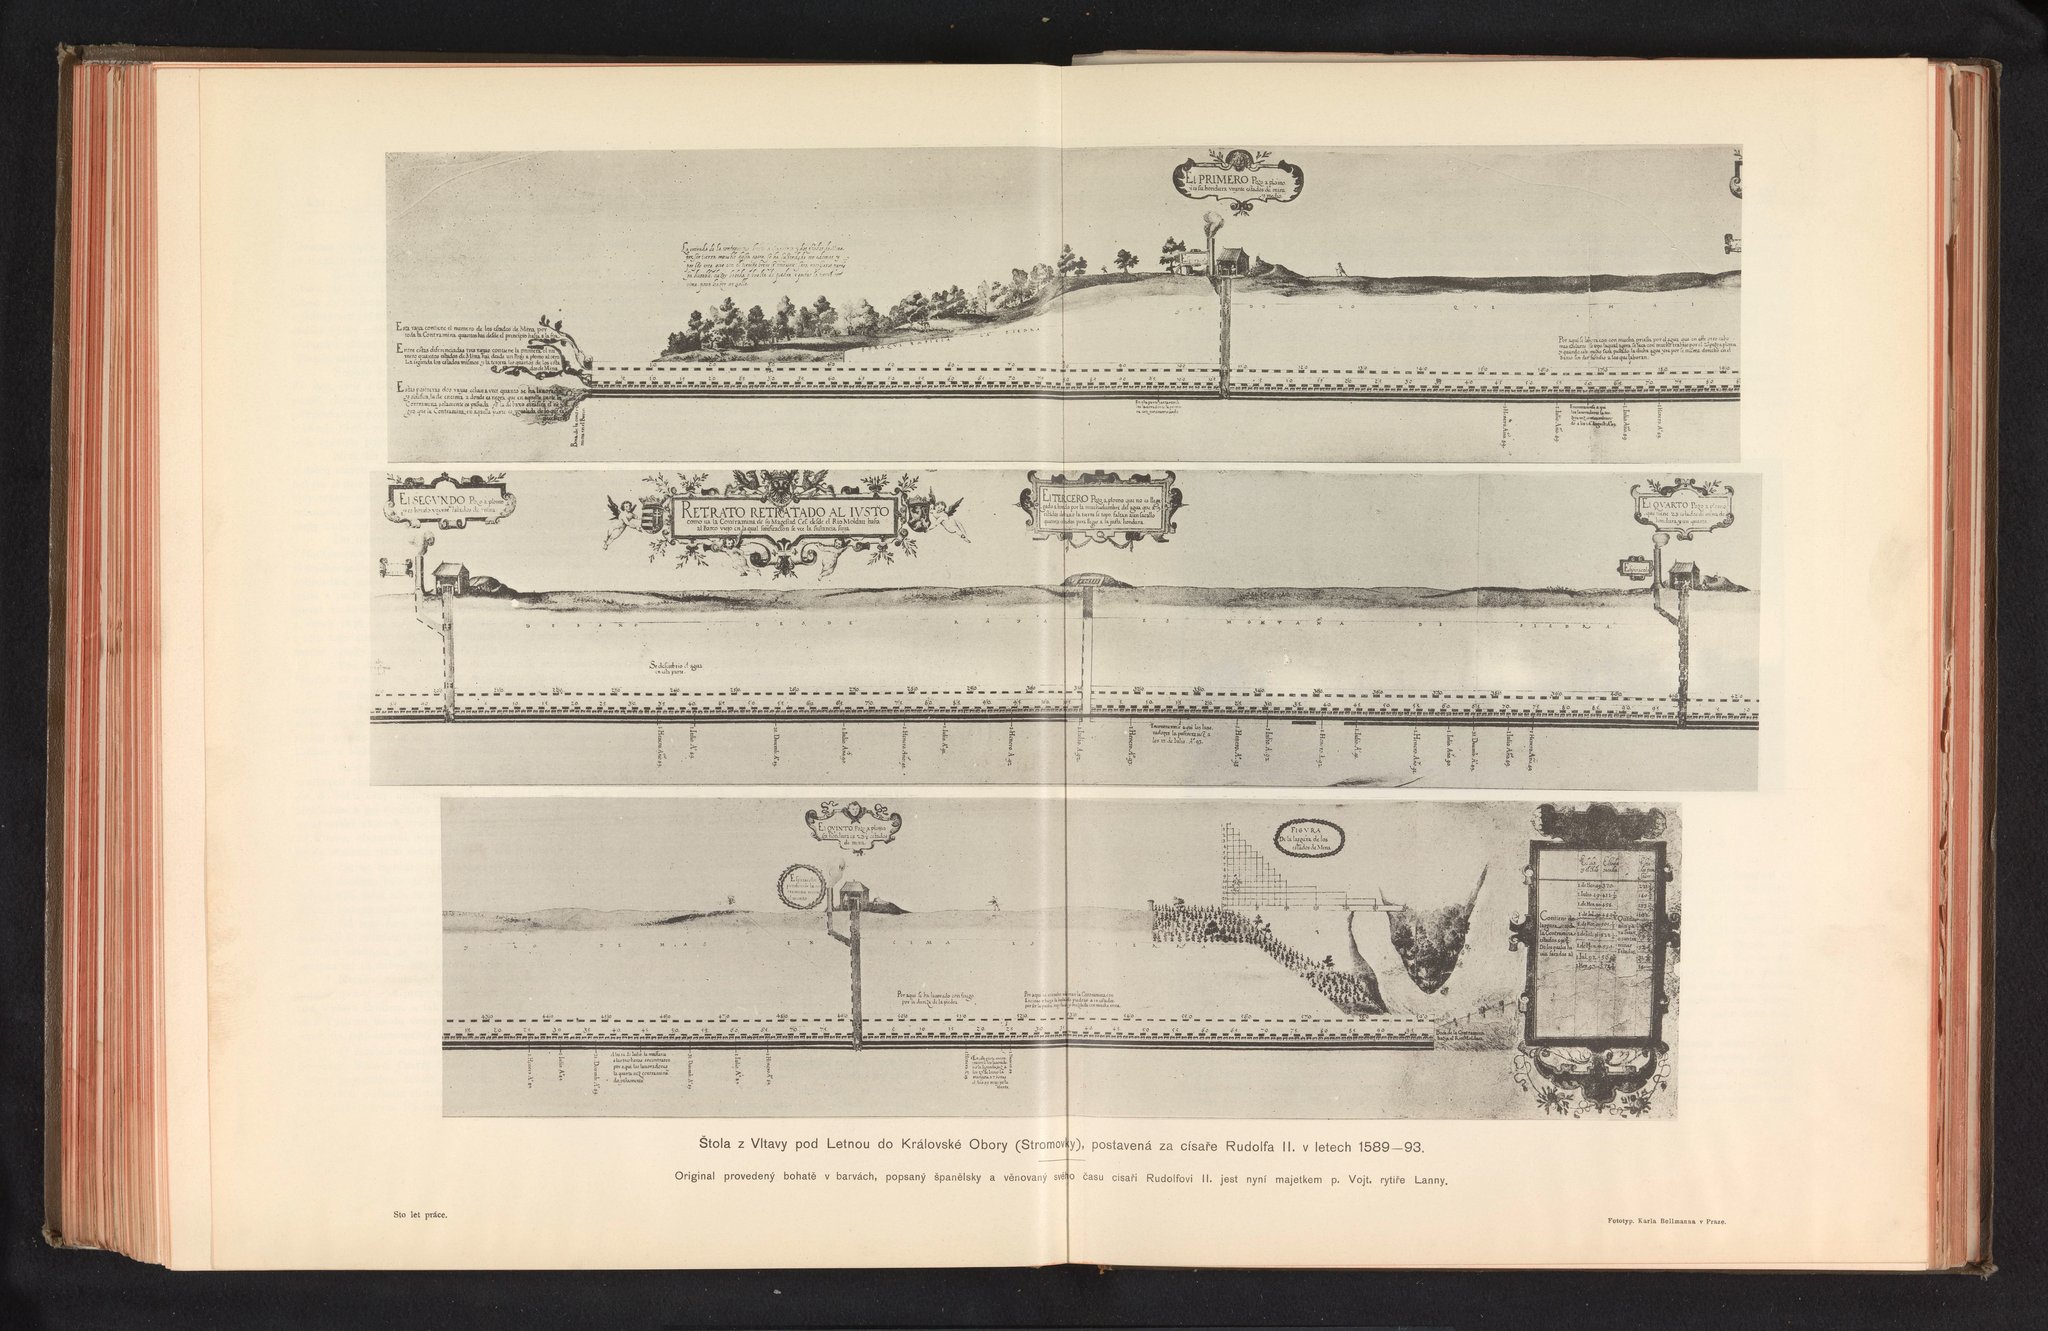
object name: page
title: Drie fotoreproducties van prent, voorstellende (vermoedelijk) waterpompen van de rivier Moldau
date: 1891-1895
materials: paper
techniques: photograph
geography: prague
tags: river, maps, atlases